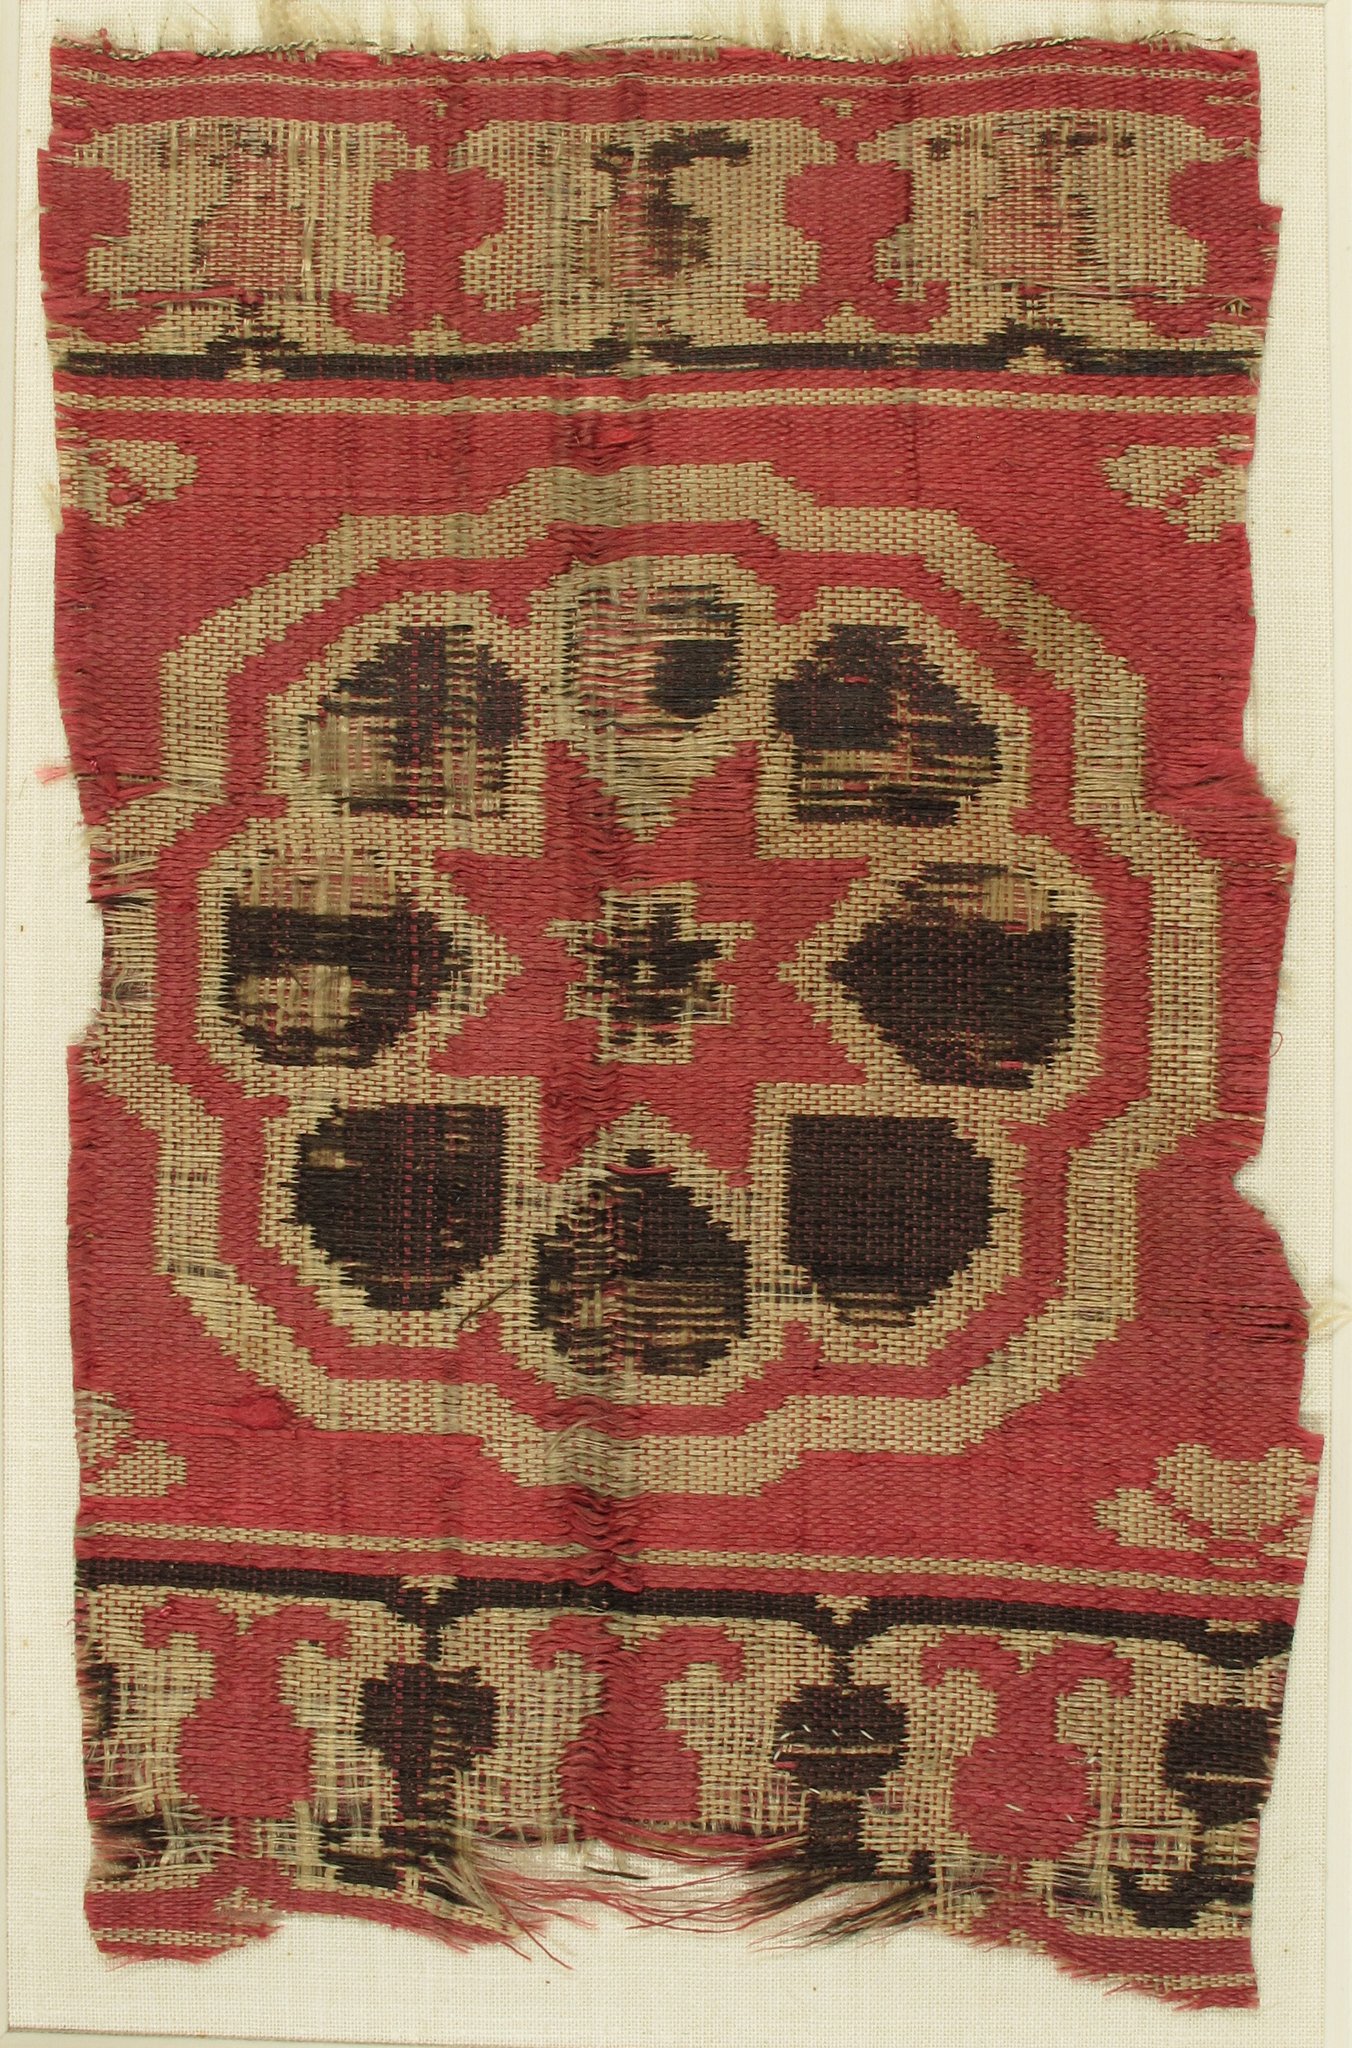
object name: textile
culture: spanish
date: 1400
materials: metal thread, silk